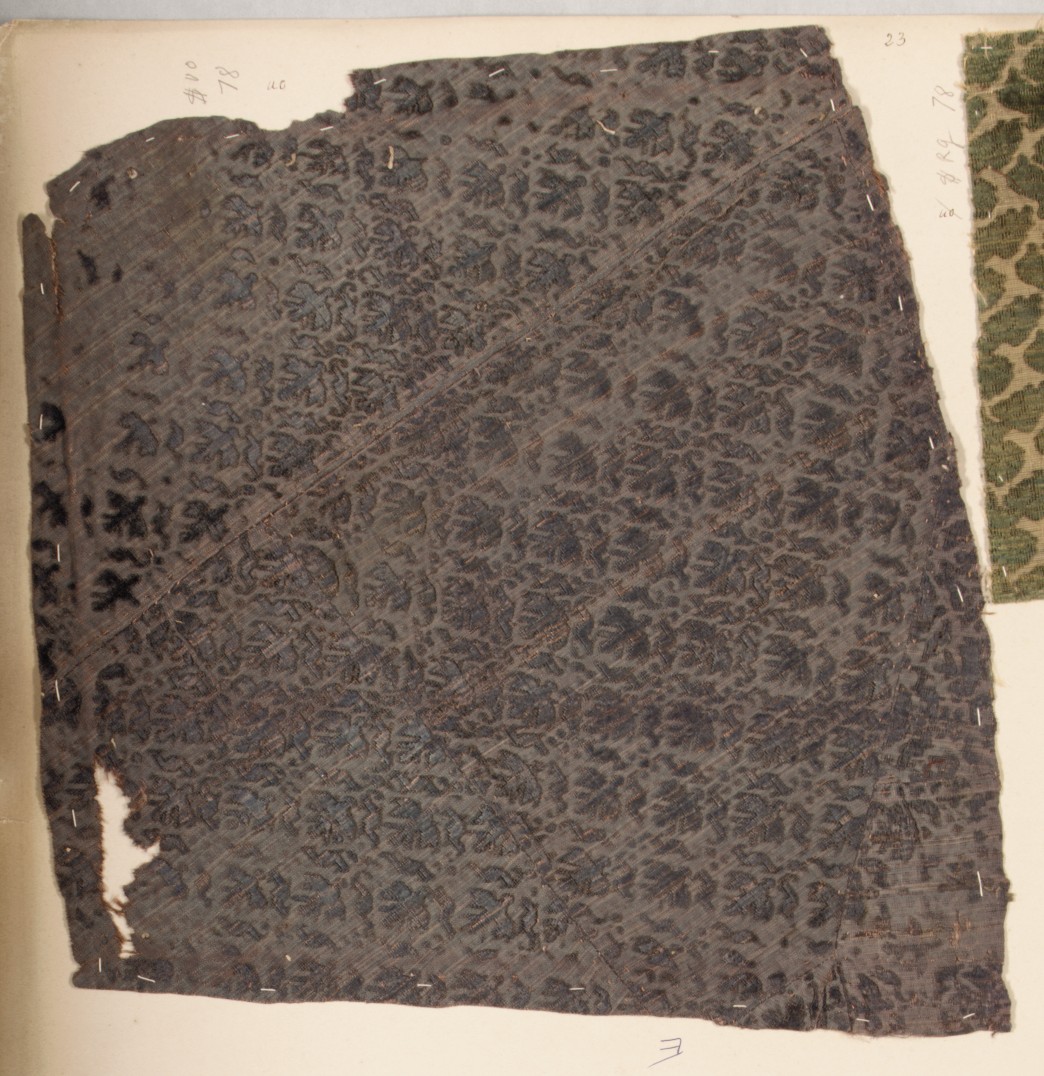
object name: fragment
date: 1501-1600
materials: silk